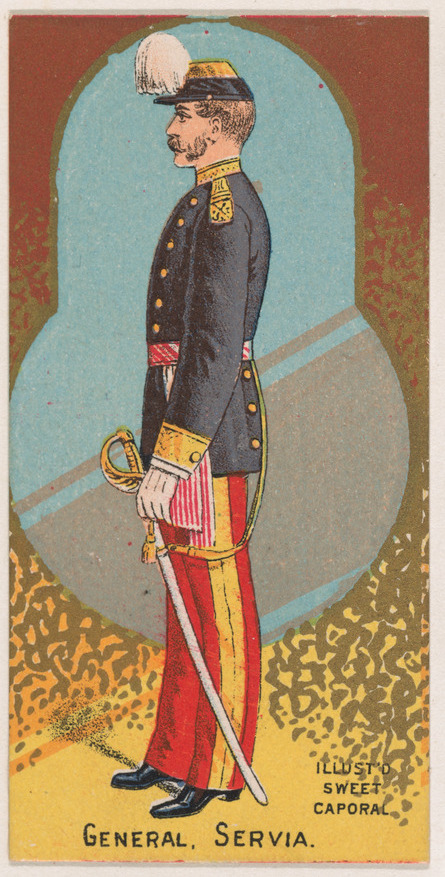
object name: print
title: General, Servia, from the Military Series (N224) issued by Kinney Tobacco Company to promote Sweet Caporal Cigarettes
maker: kinney brothers tobacco company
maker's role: publisher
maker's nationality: american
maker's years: 1869-2011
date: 1888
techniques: color lithograph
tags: military,men,profiles,generals